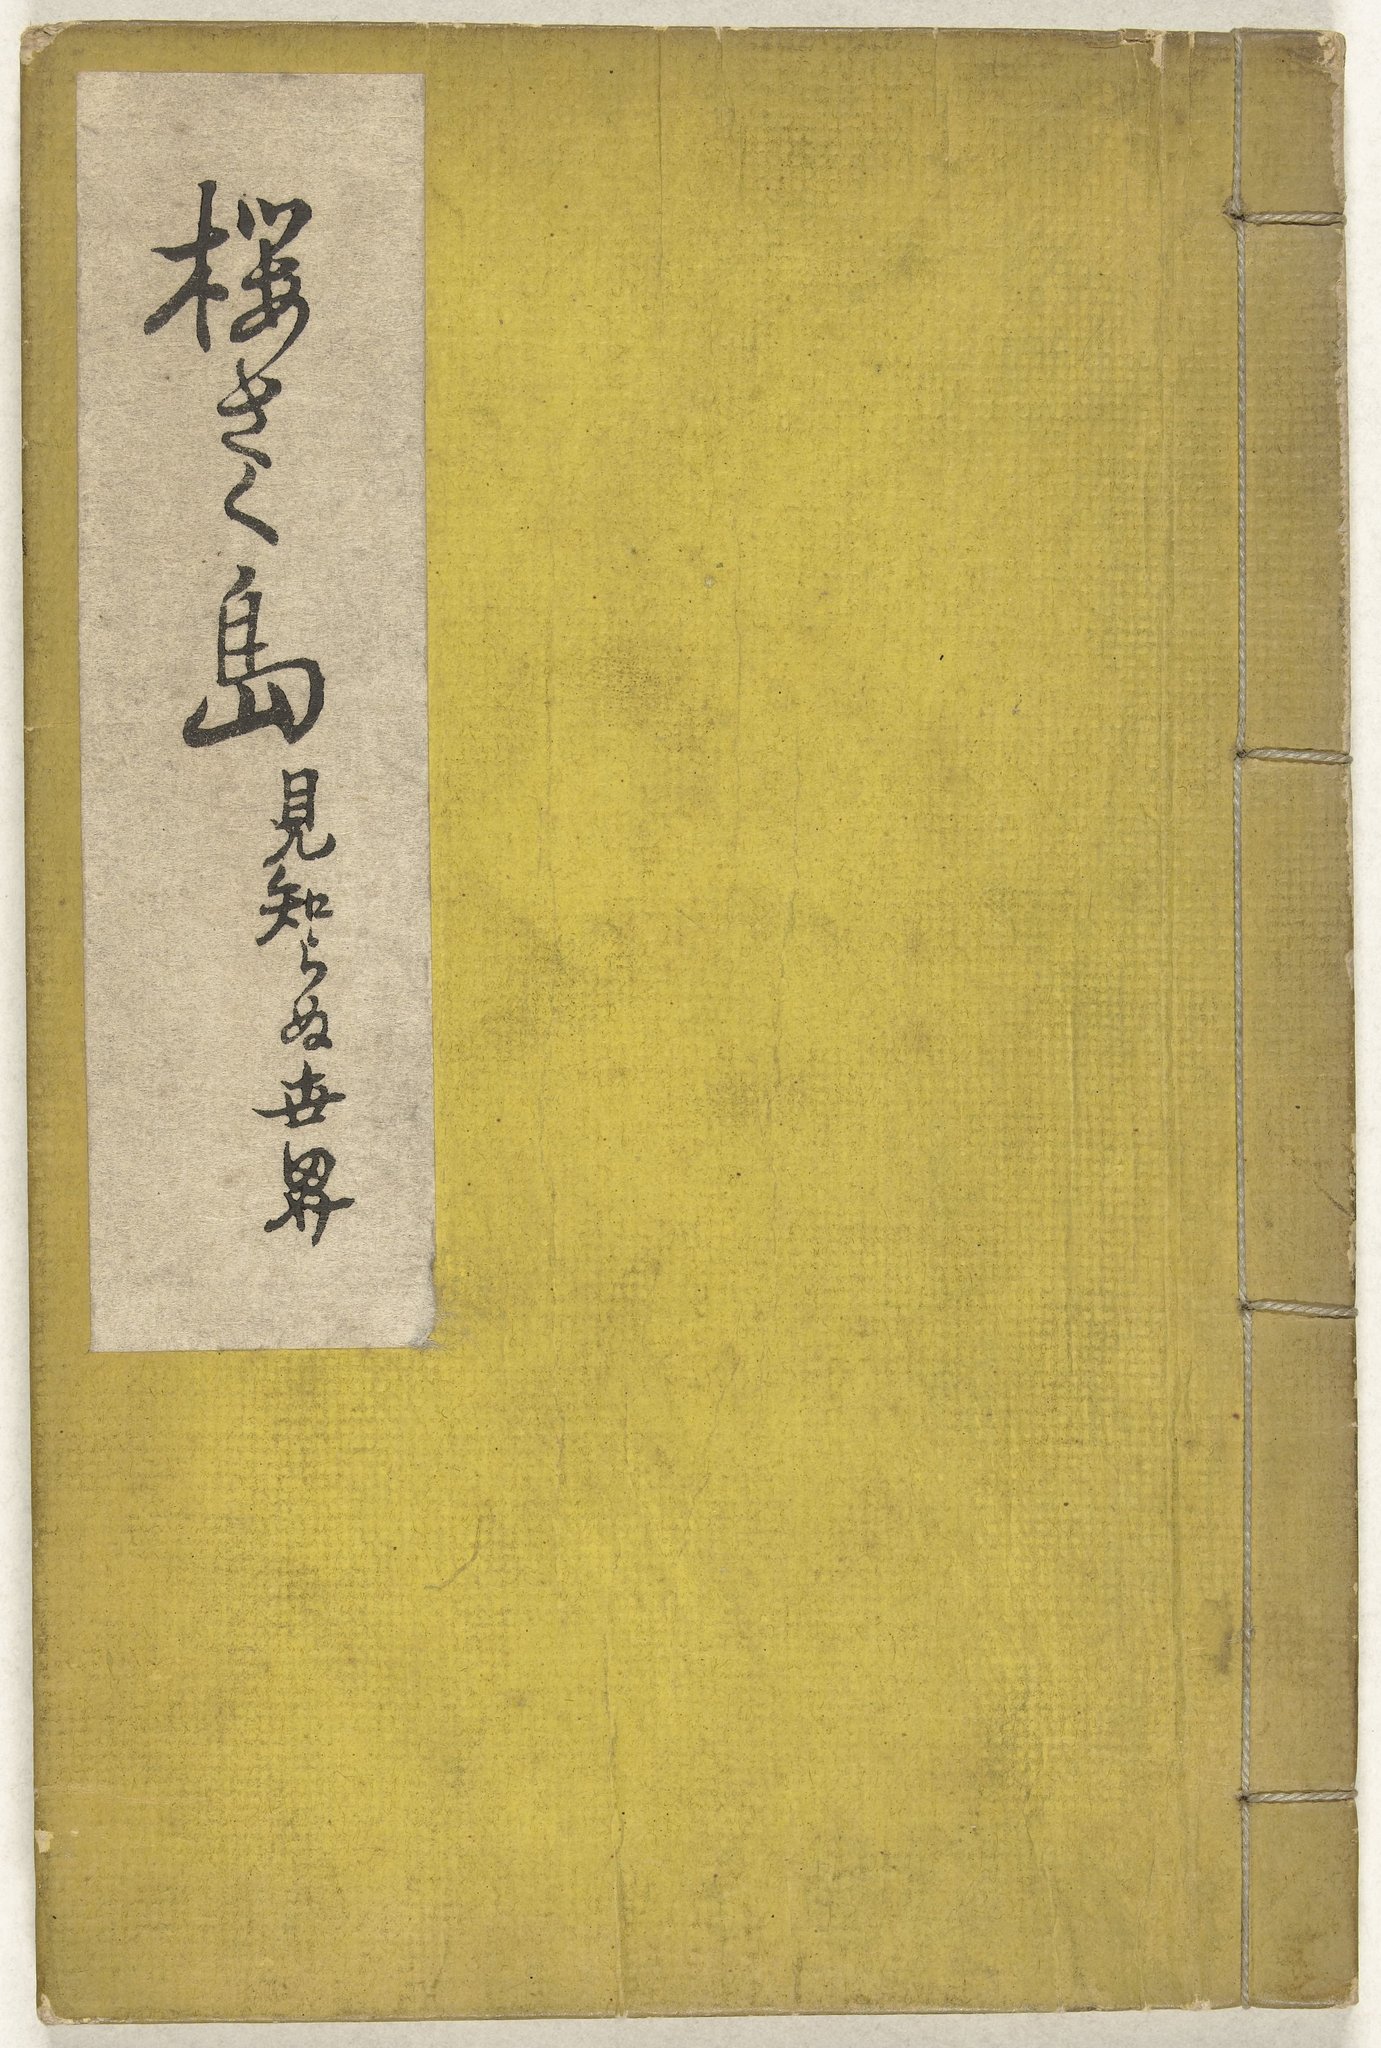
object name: book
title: Sakurasaku shima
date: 1904-1912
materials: paper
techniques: woodcut, letterpress printing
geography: tokyo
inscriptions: date